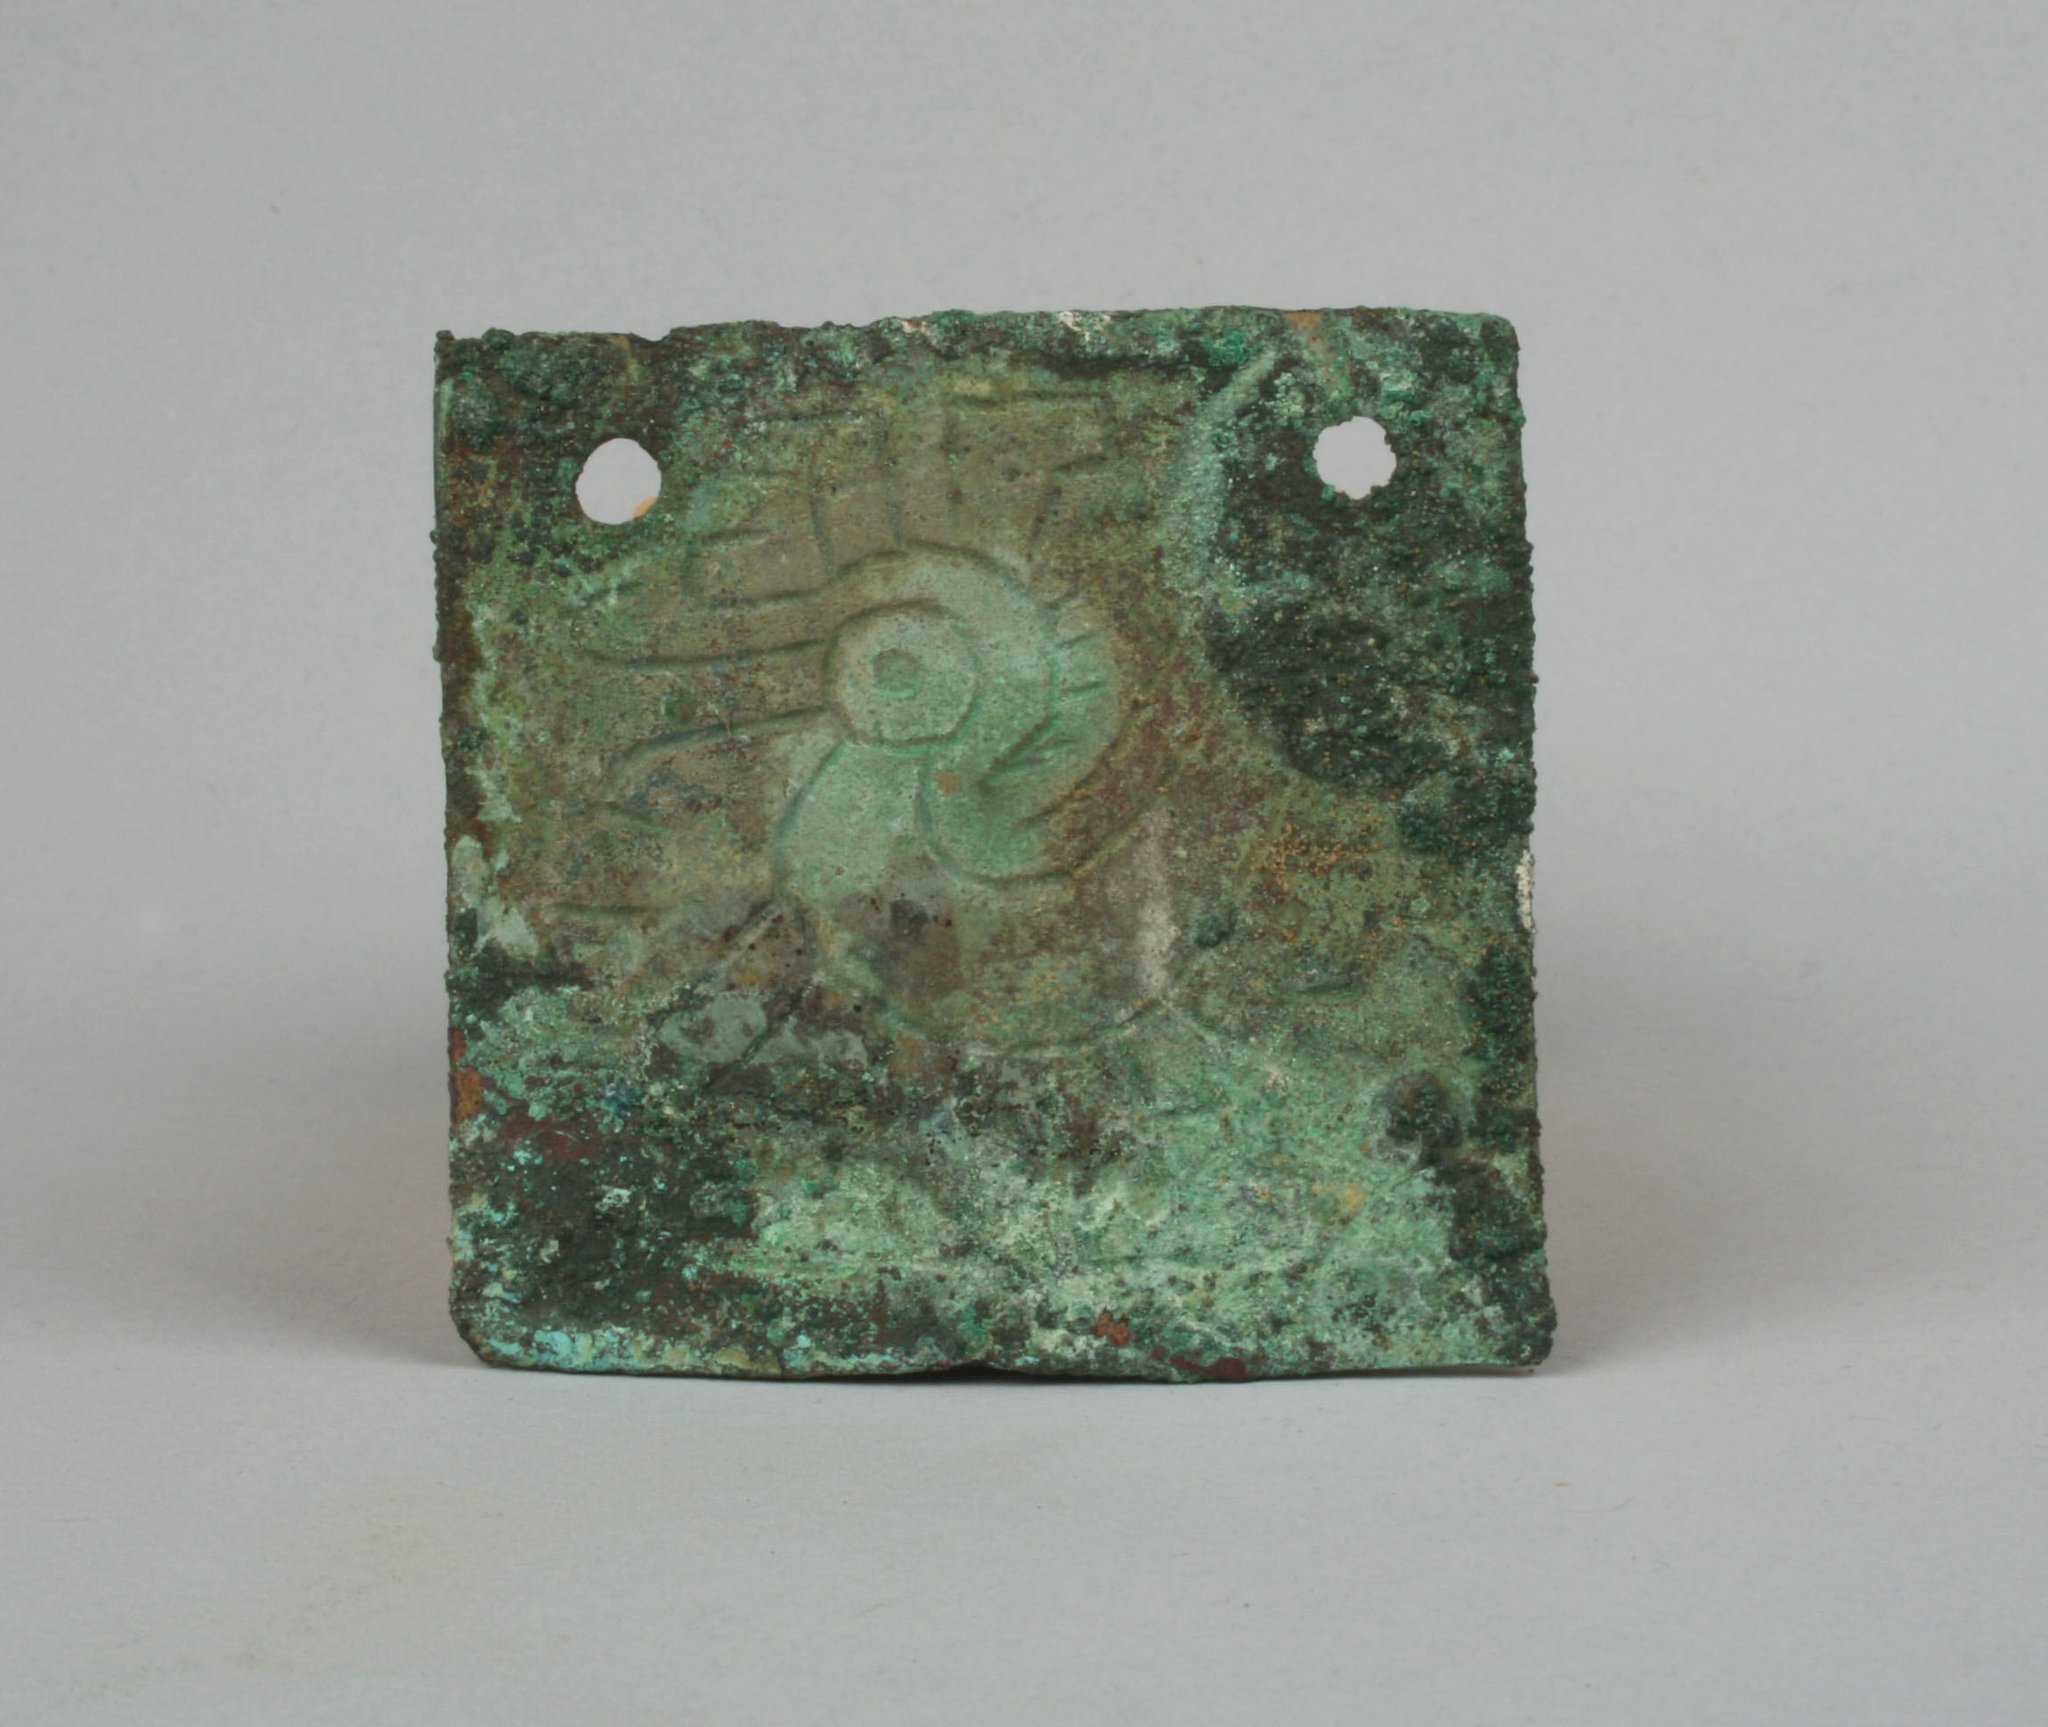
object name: ornament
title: Bird Plaque Ornament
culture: vicús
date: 300 BCE-200 CE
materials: copper, gilt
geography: peru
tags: birds